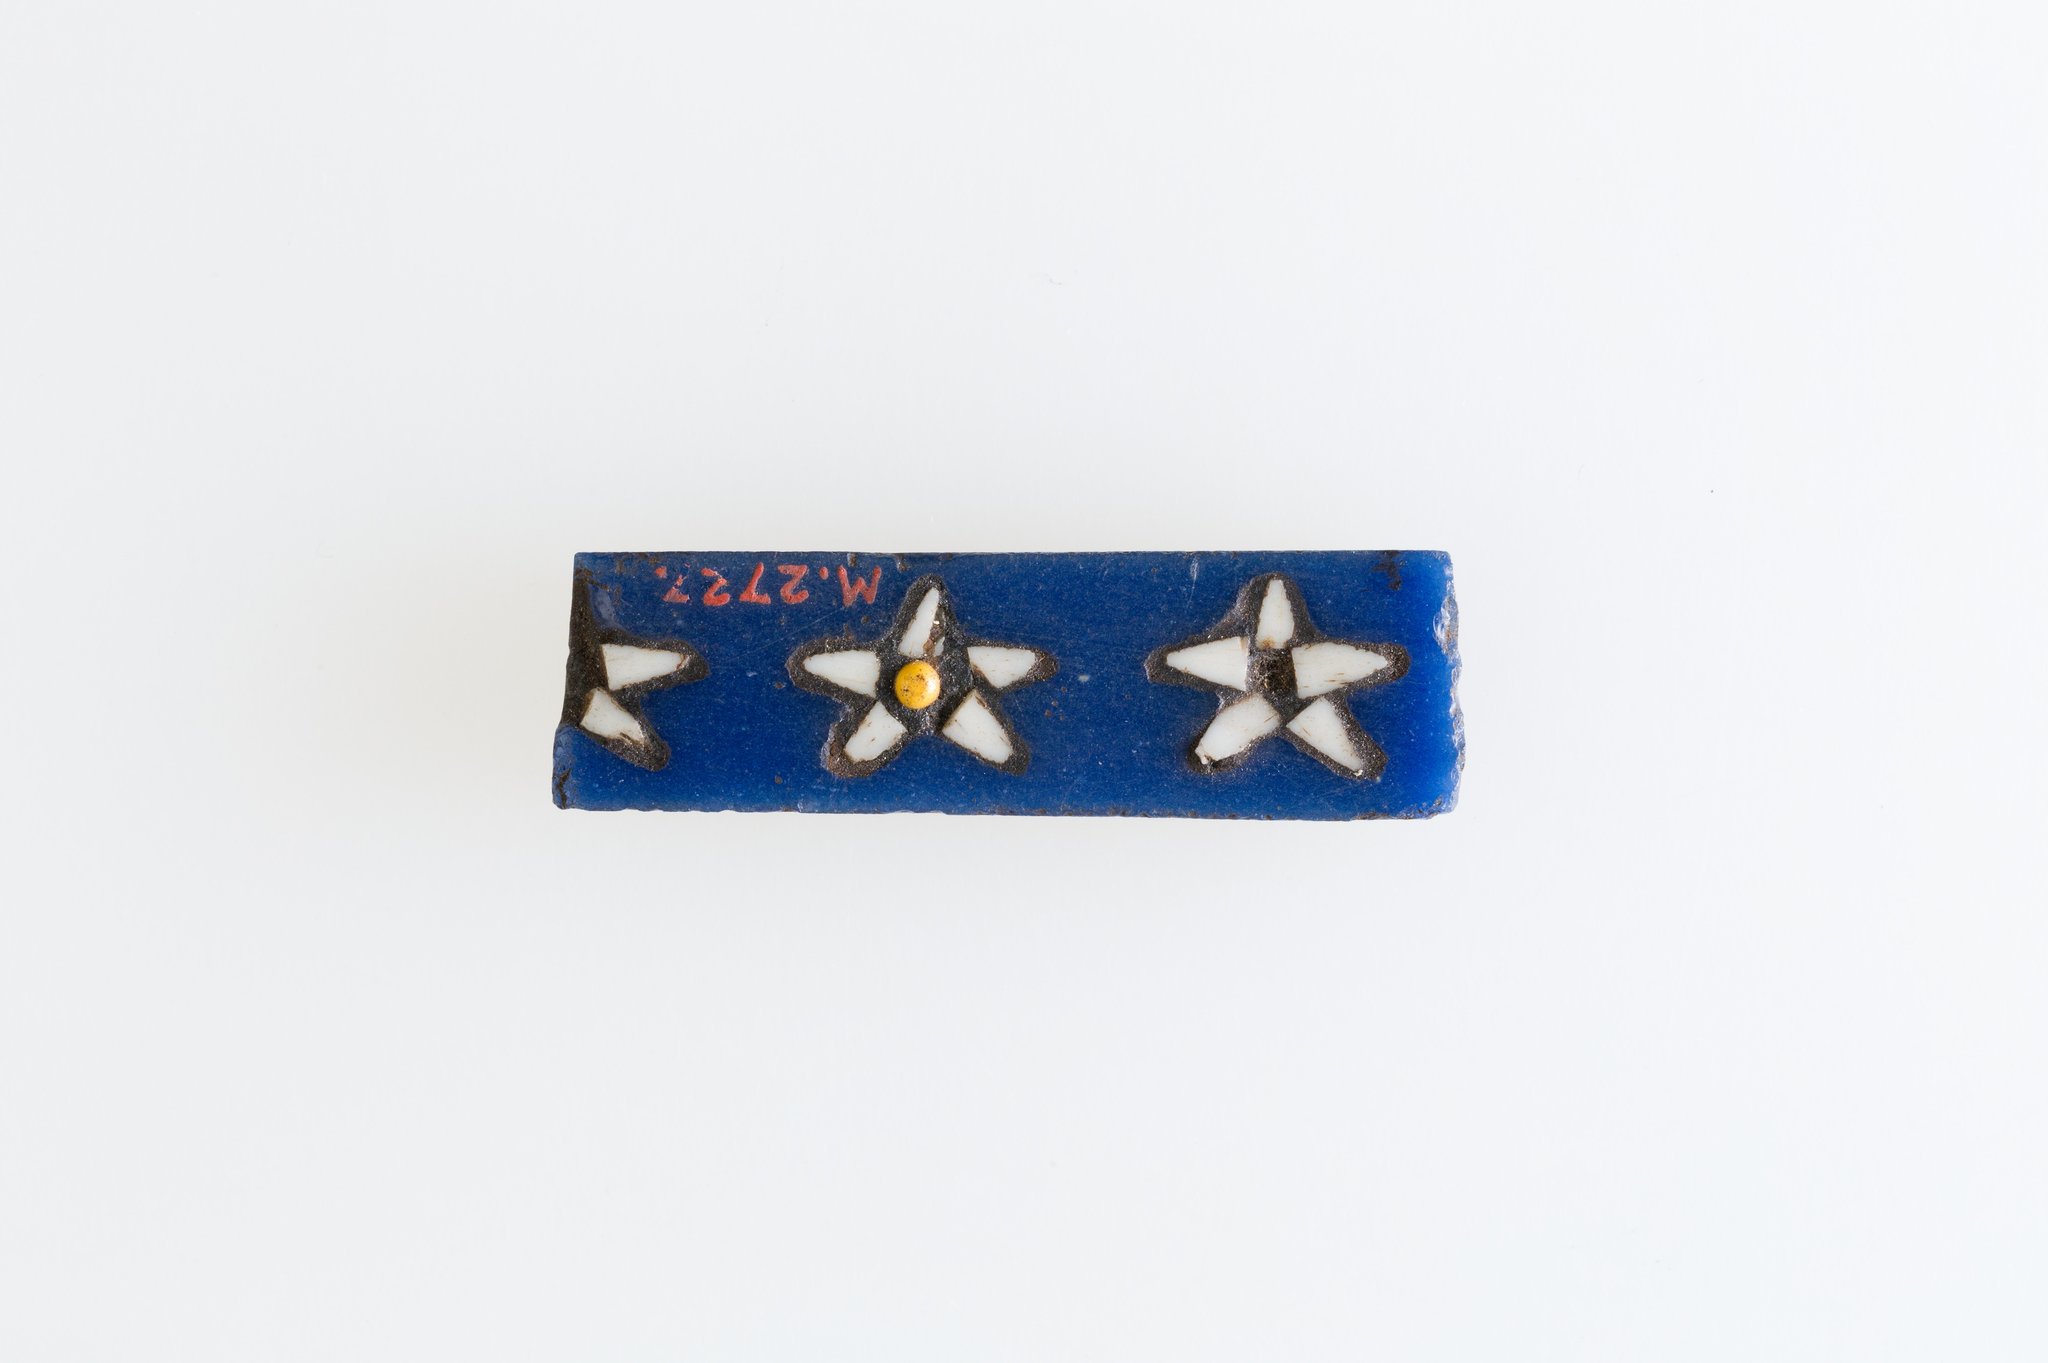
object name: inlay, star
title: Inlay fragment, row of stars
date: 200 BCE-100 CE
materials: glass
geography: egypt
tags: stars